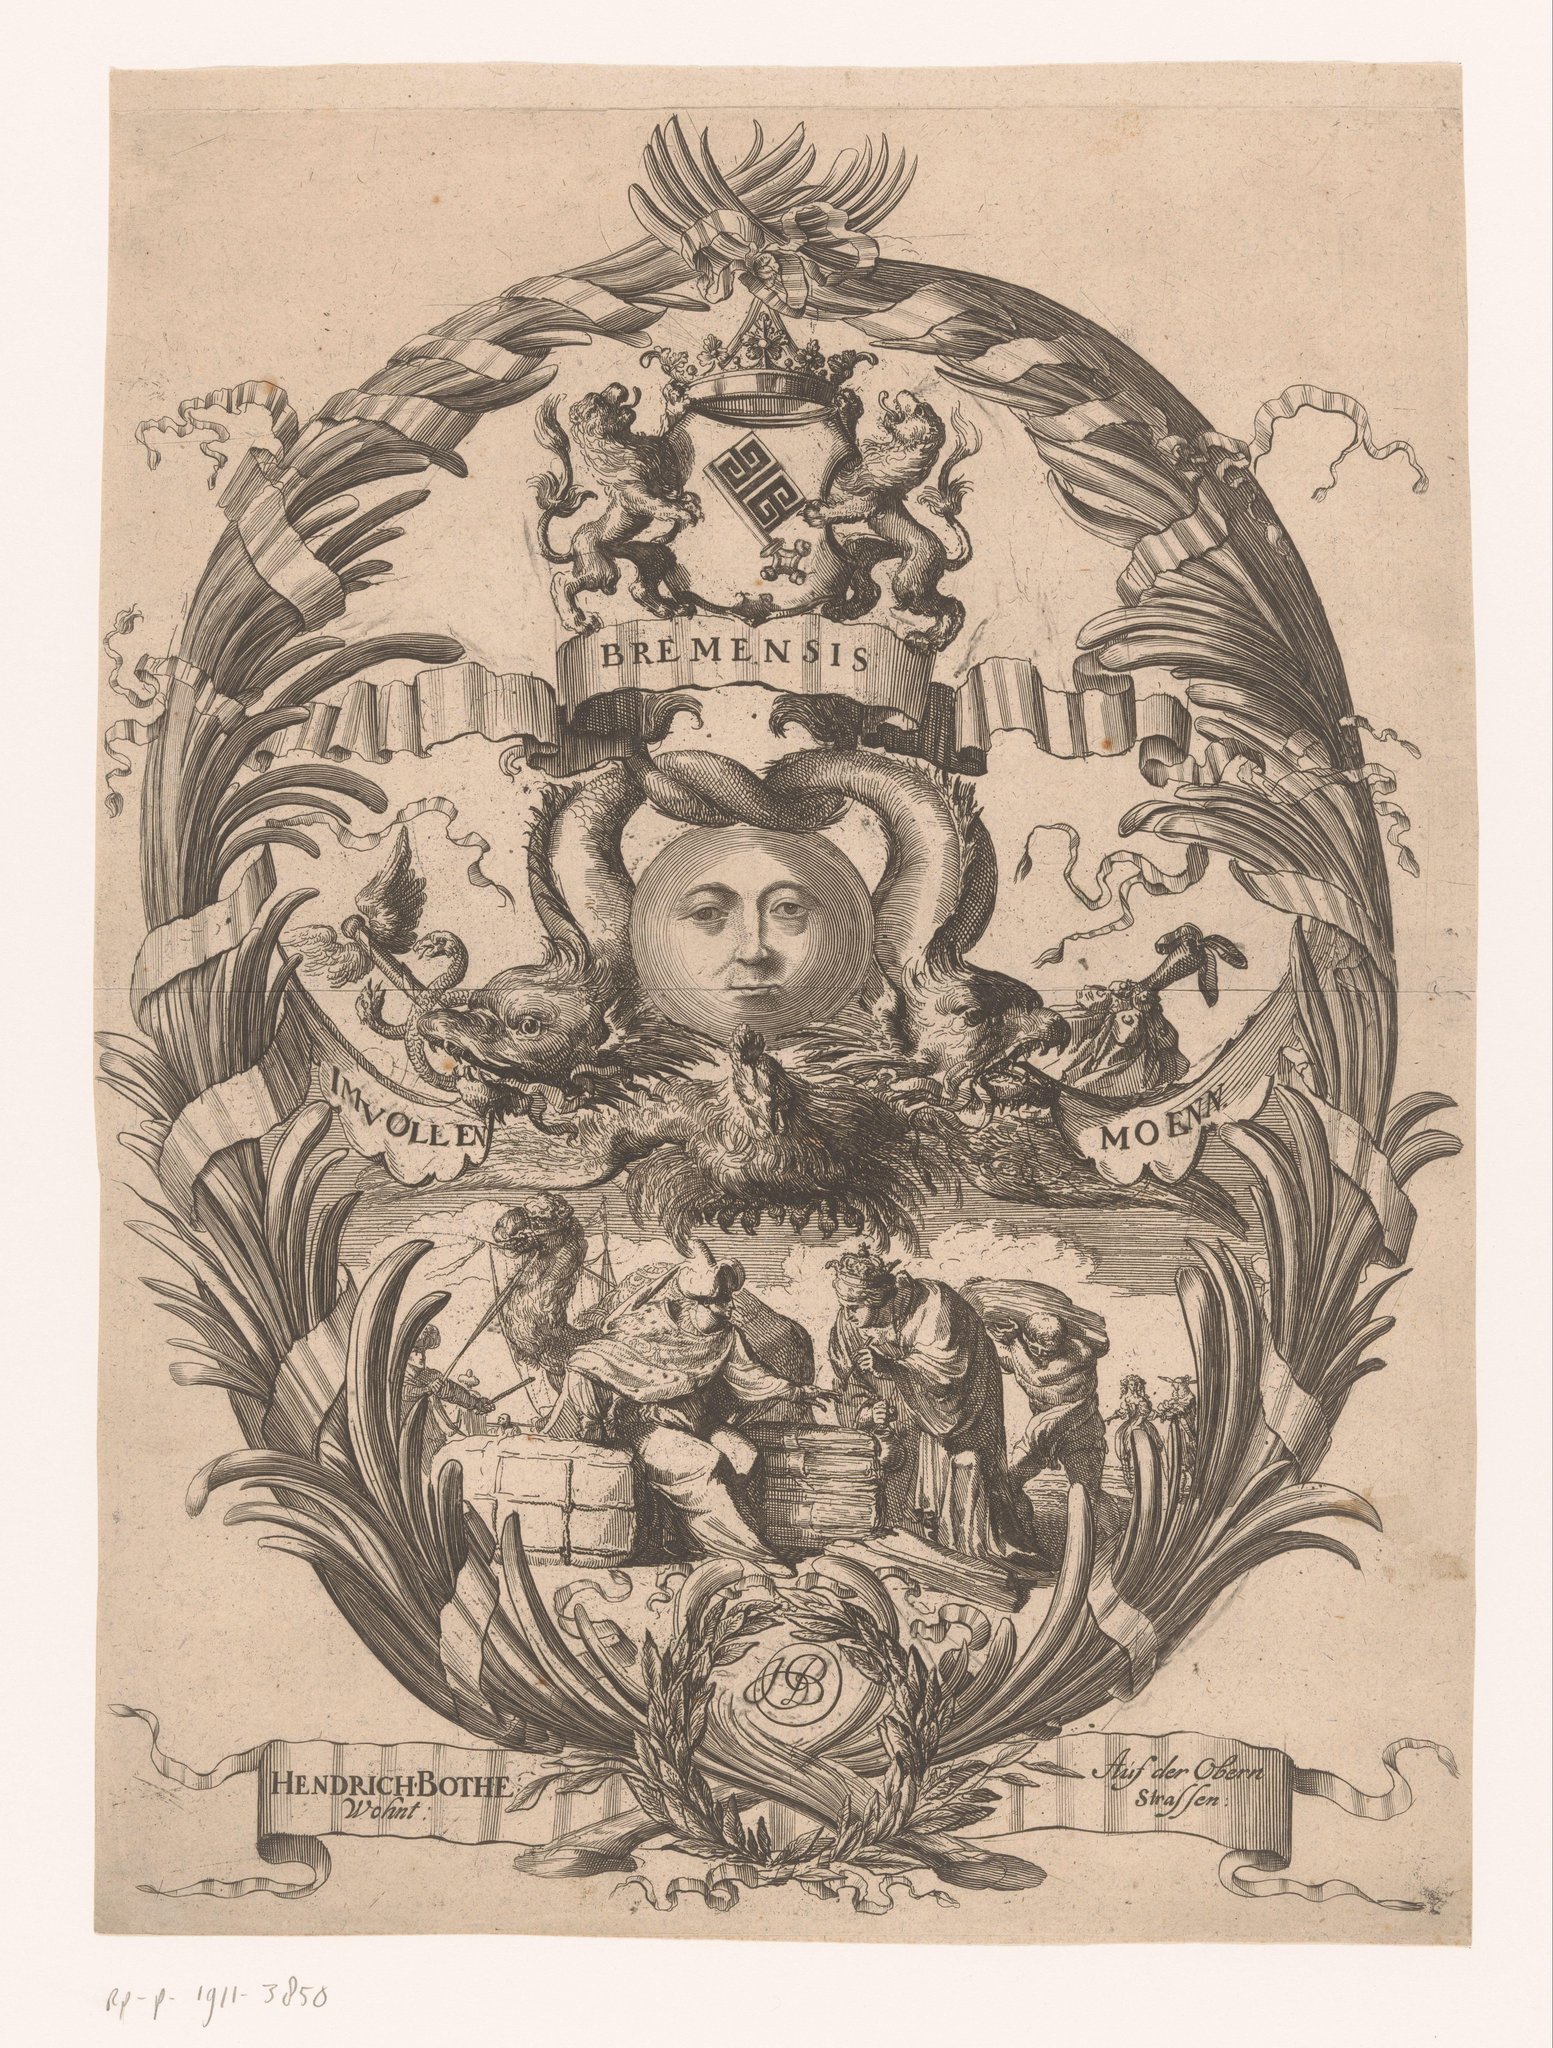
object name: print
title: Handelsmerk van Jan Both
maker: Anonymous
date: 1600-1699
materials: paper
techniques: etching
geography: germany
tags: utrecht, painter, print maker, draughtsman, jan both, trade mark, trade token, trade sign, trade card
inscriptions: collector's mark: Lugt 2228